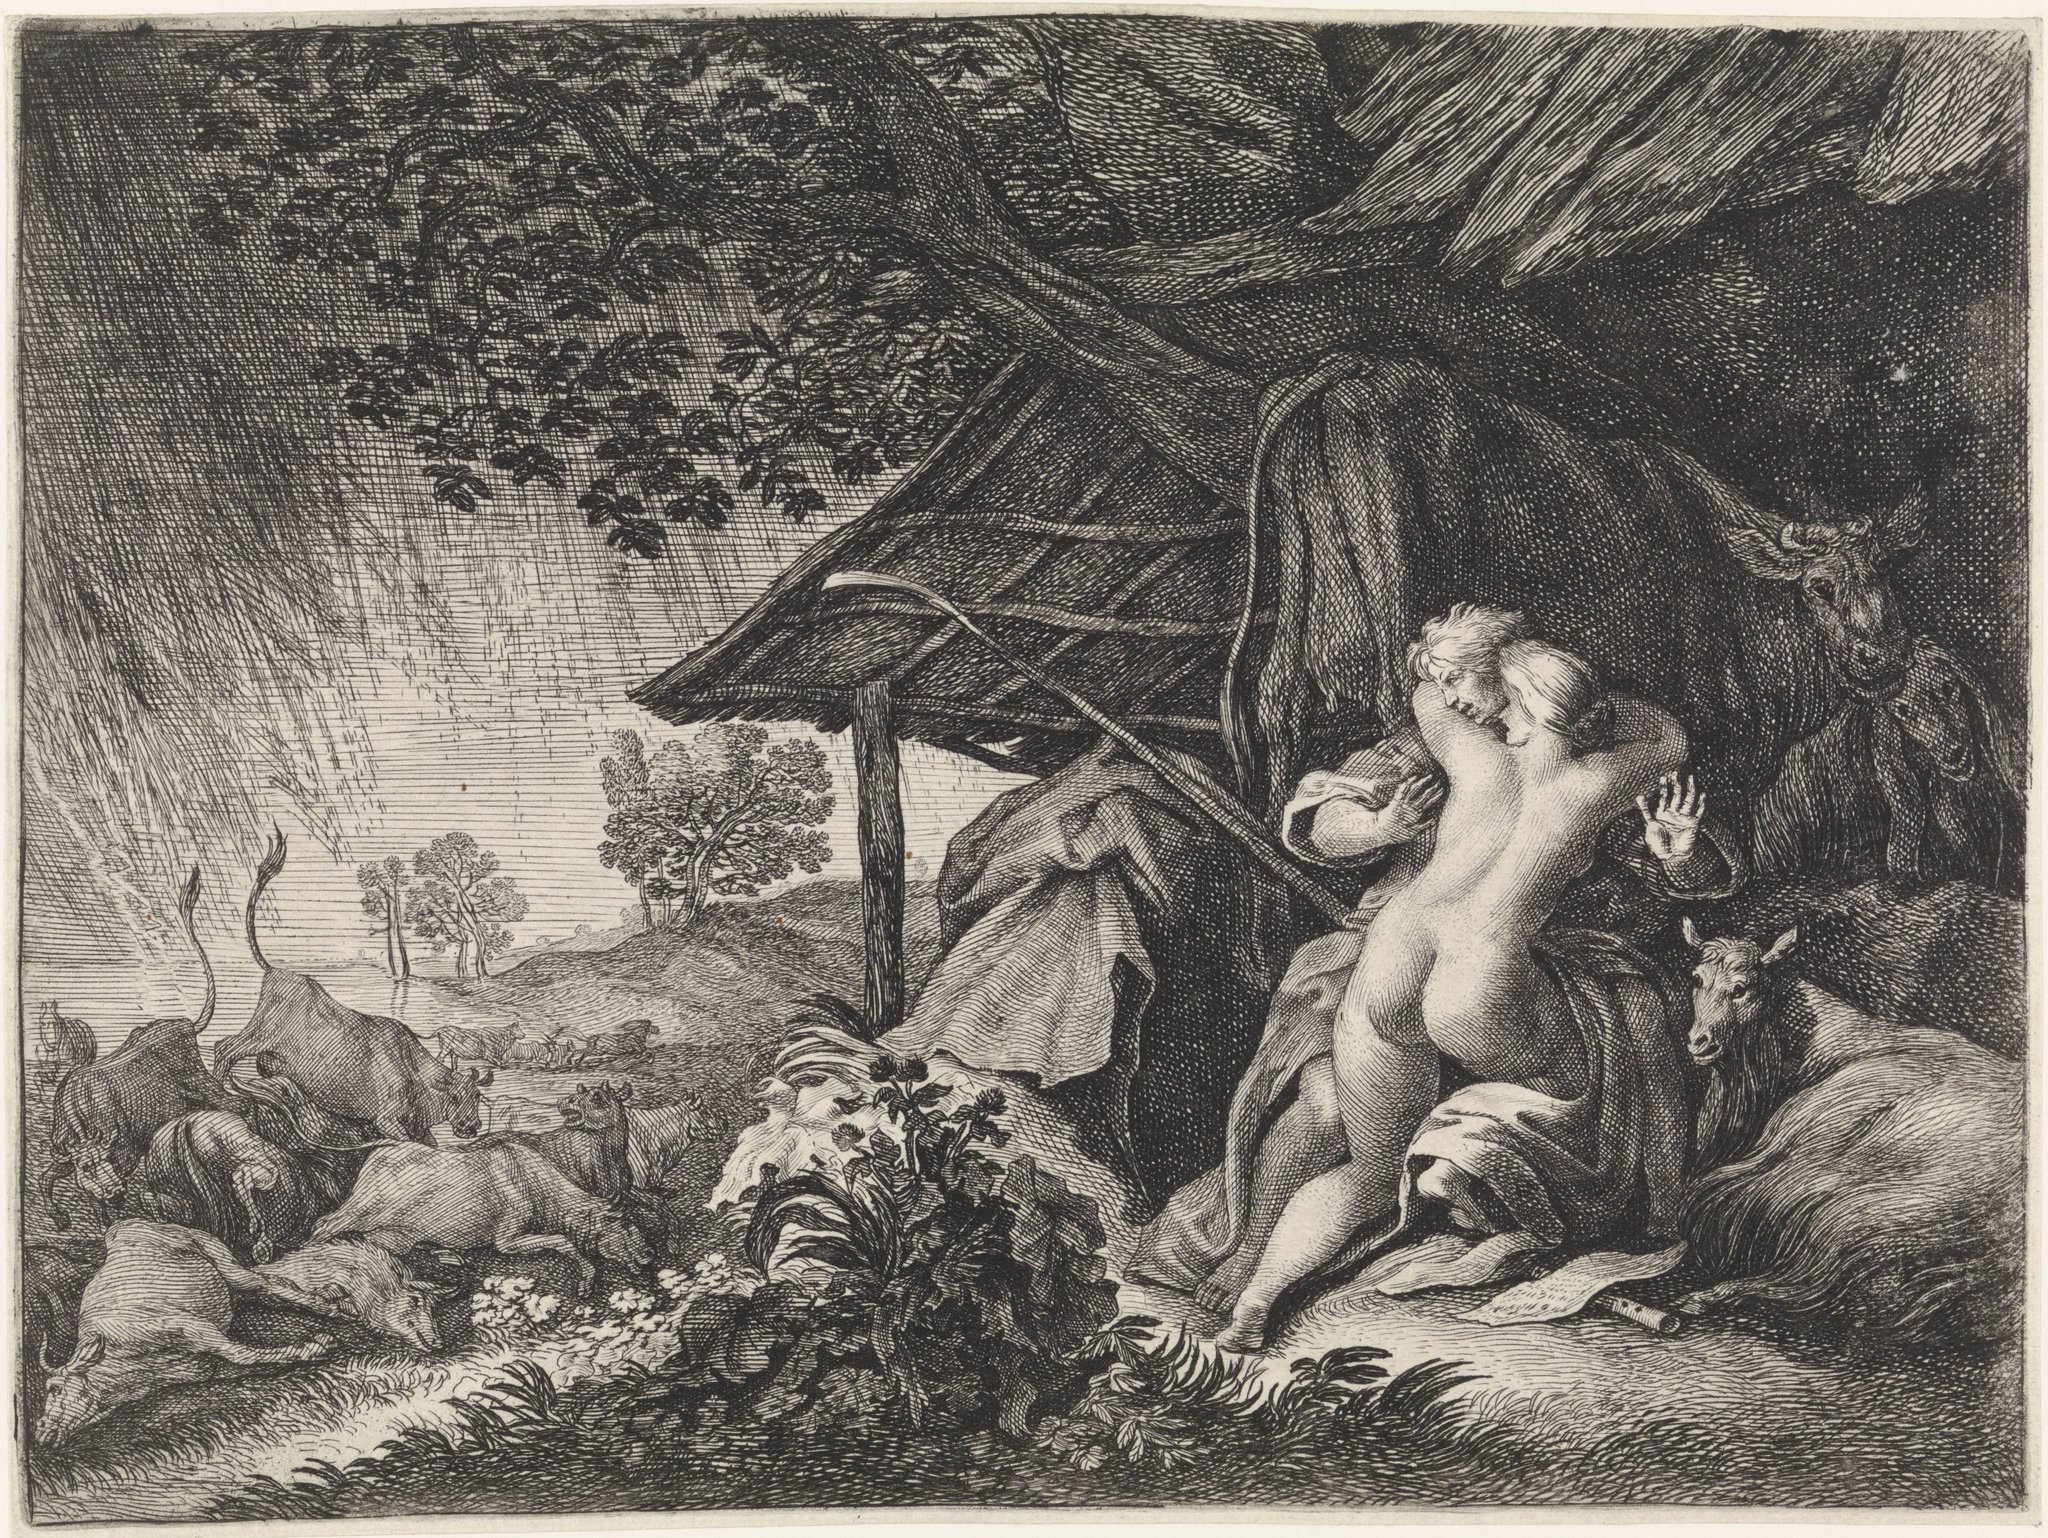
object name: print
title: Herder en herderin schuilend voor een storm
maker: moyses van wtenbrouck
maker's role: painter, print maker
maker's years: 1590-1647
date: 1600-1647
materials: paper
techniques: engraving, etching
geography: the hague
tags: thunderstorm, pastorals, arcadian scenes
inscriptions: collector's mark: Lugt 240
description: De herder en herderin schuilen onder een afdak in elkaars armen voor een hevige storm. Op de grond een fluit en bladmuziek. Een kudde koeien, over elkaar heen vallend, vlucht in paniek.